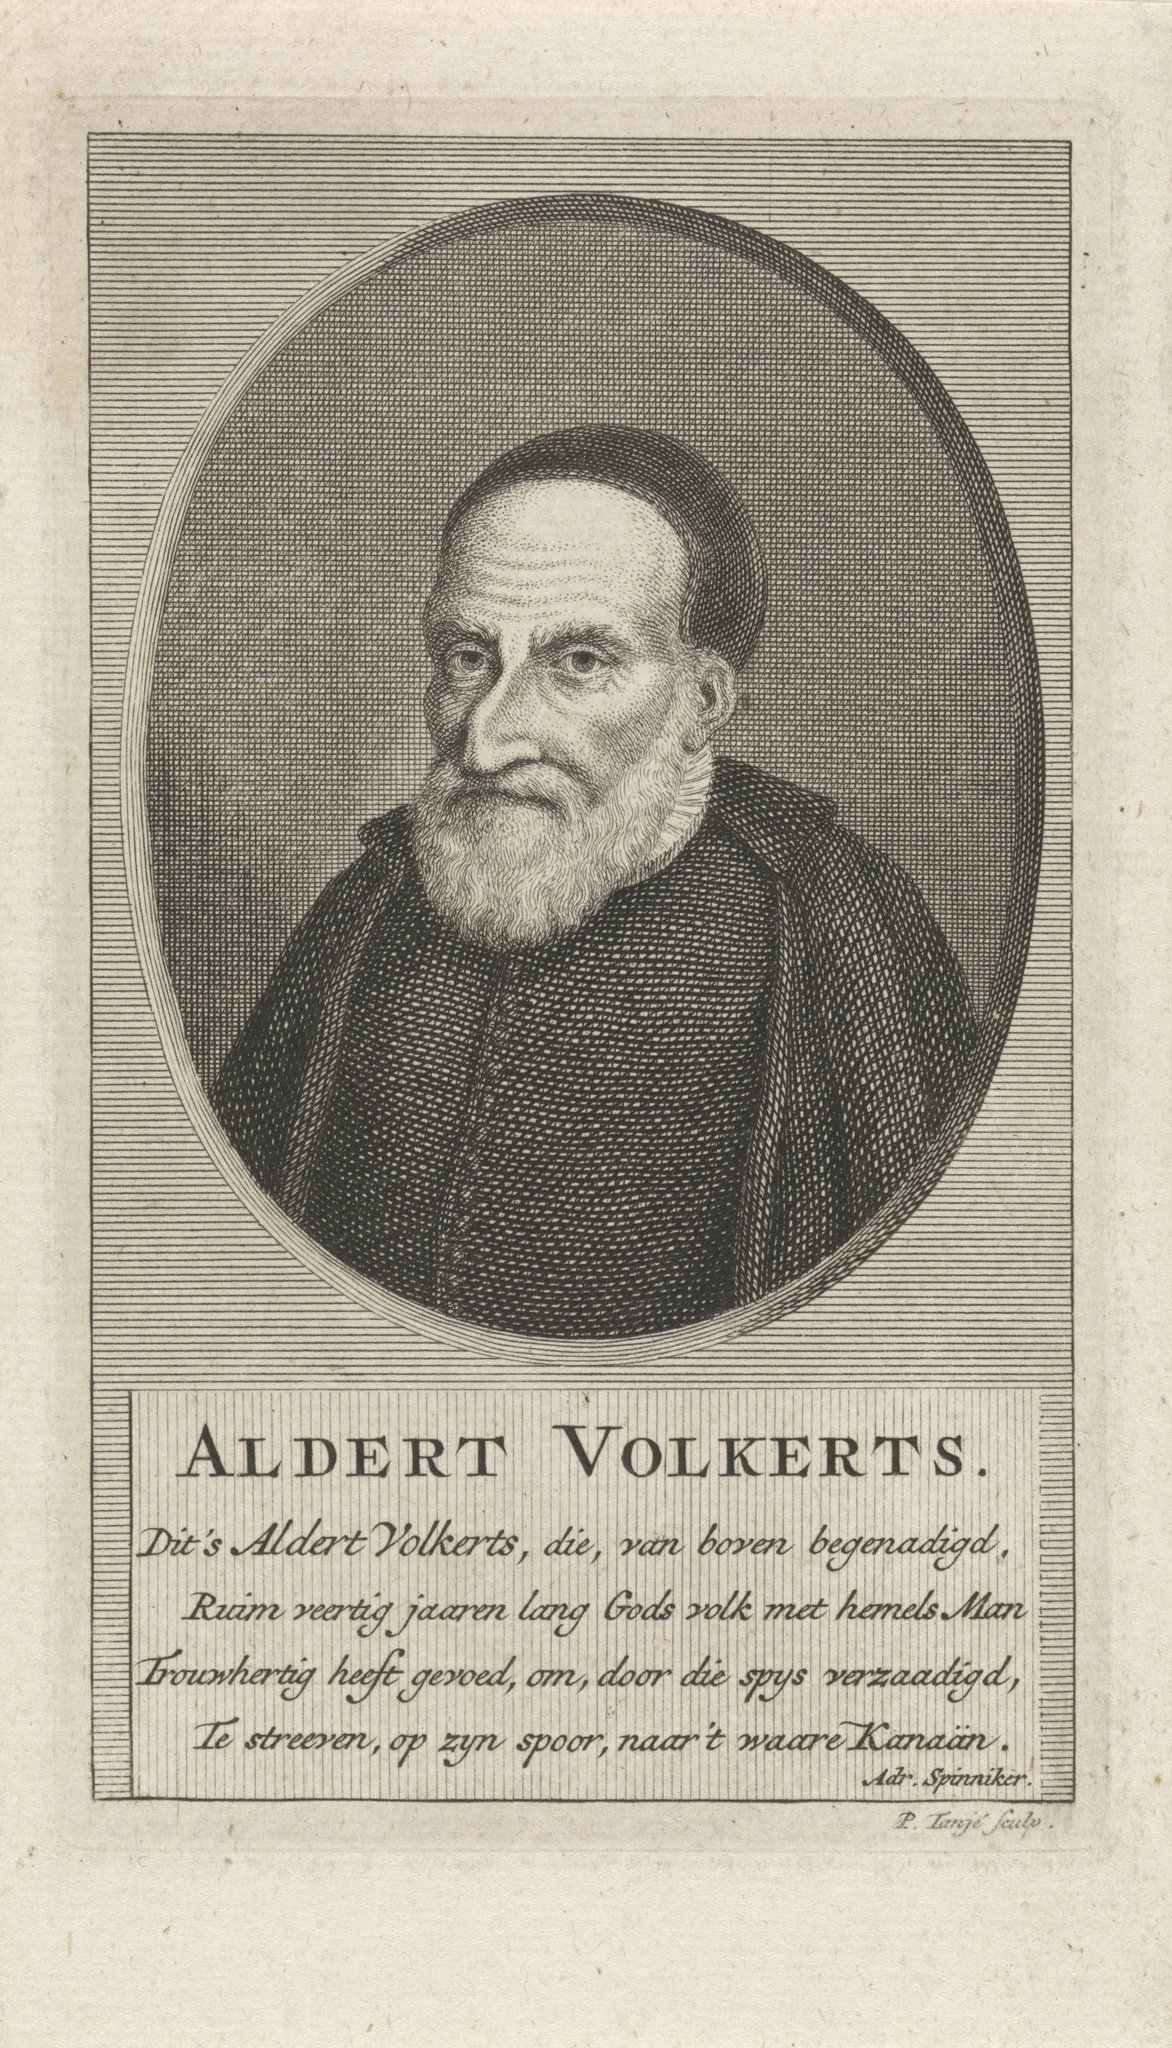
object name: print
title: Portret van Aldert Volkerts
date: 1716-1761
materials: paper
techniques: engraving, etching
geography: amsterdam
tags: predikant, aldert volkerts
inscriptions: collector's mark: Lugt 2228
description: Portret van Aldert Volkerts, doopsgezind predikant te Amsterdam. Onder zijn portret een vierregelig vers in het Nederlands.